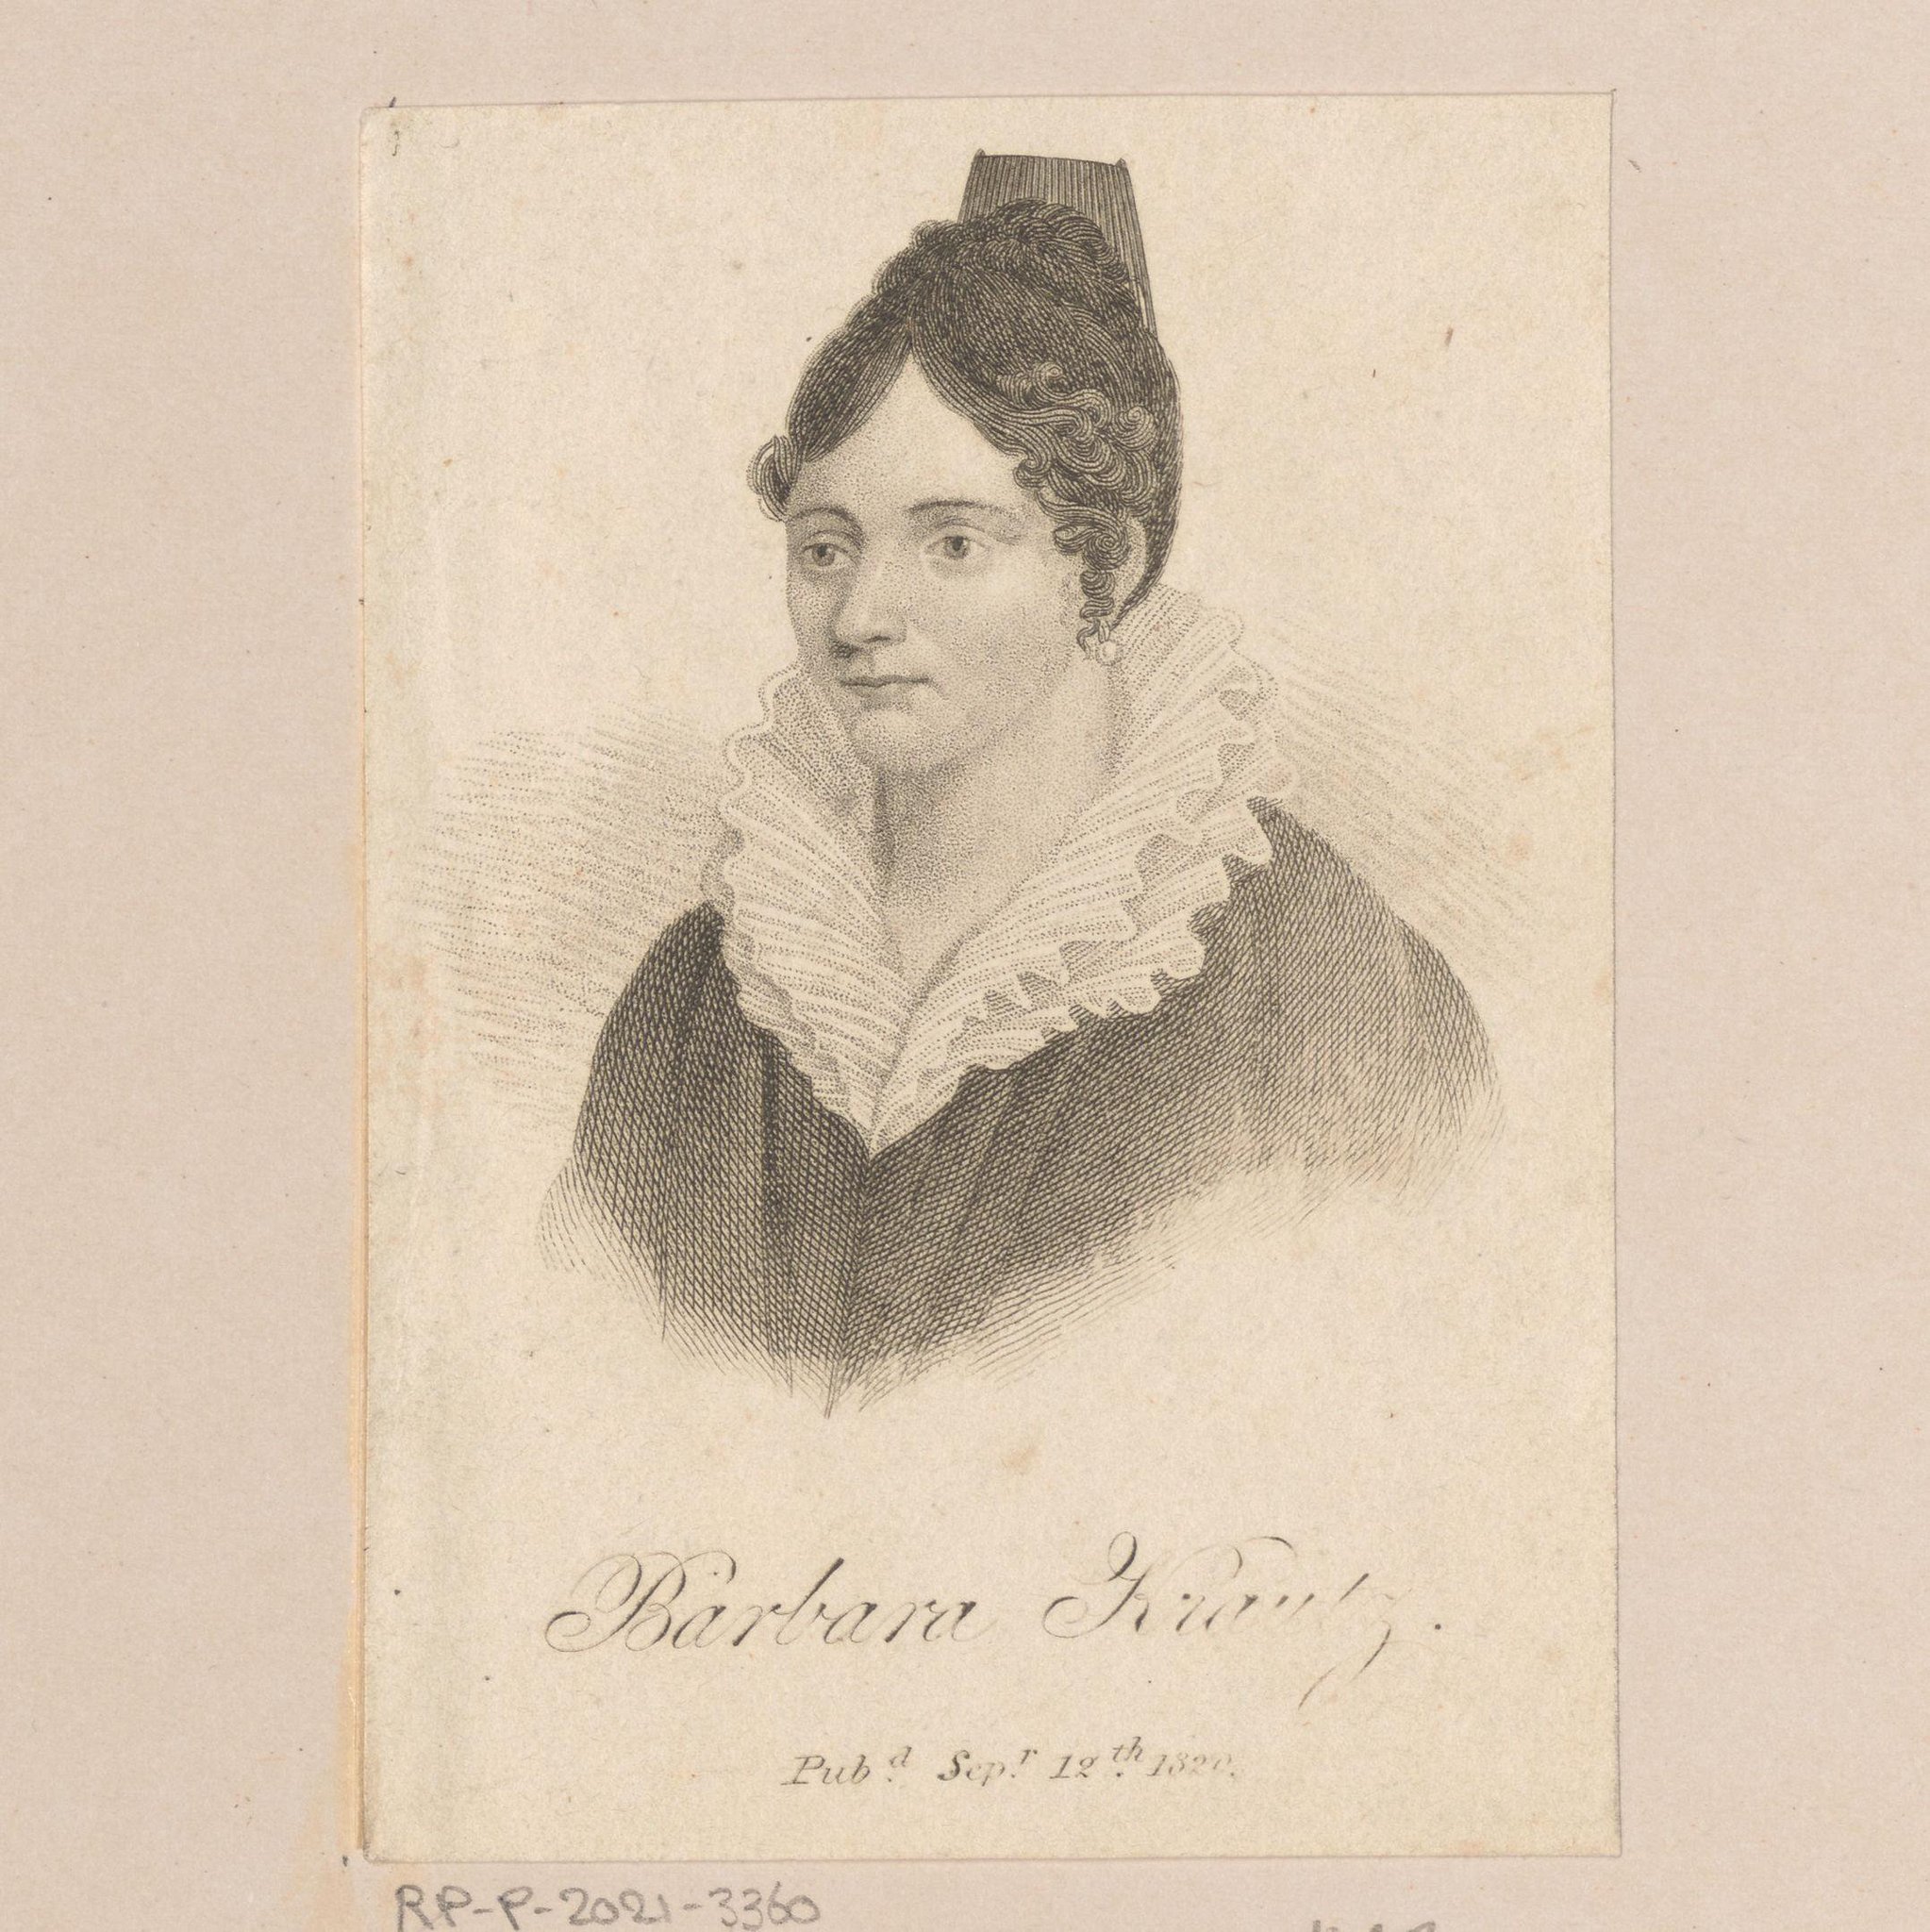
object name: print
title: Portret van Barbara Krautz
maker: Anonymous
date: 1820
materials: paper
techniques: engraving, etching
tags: historical persons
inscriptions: date